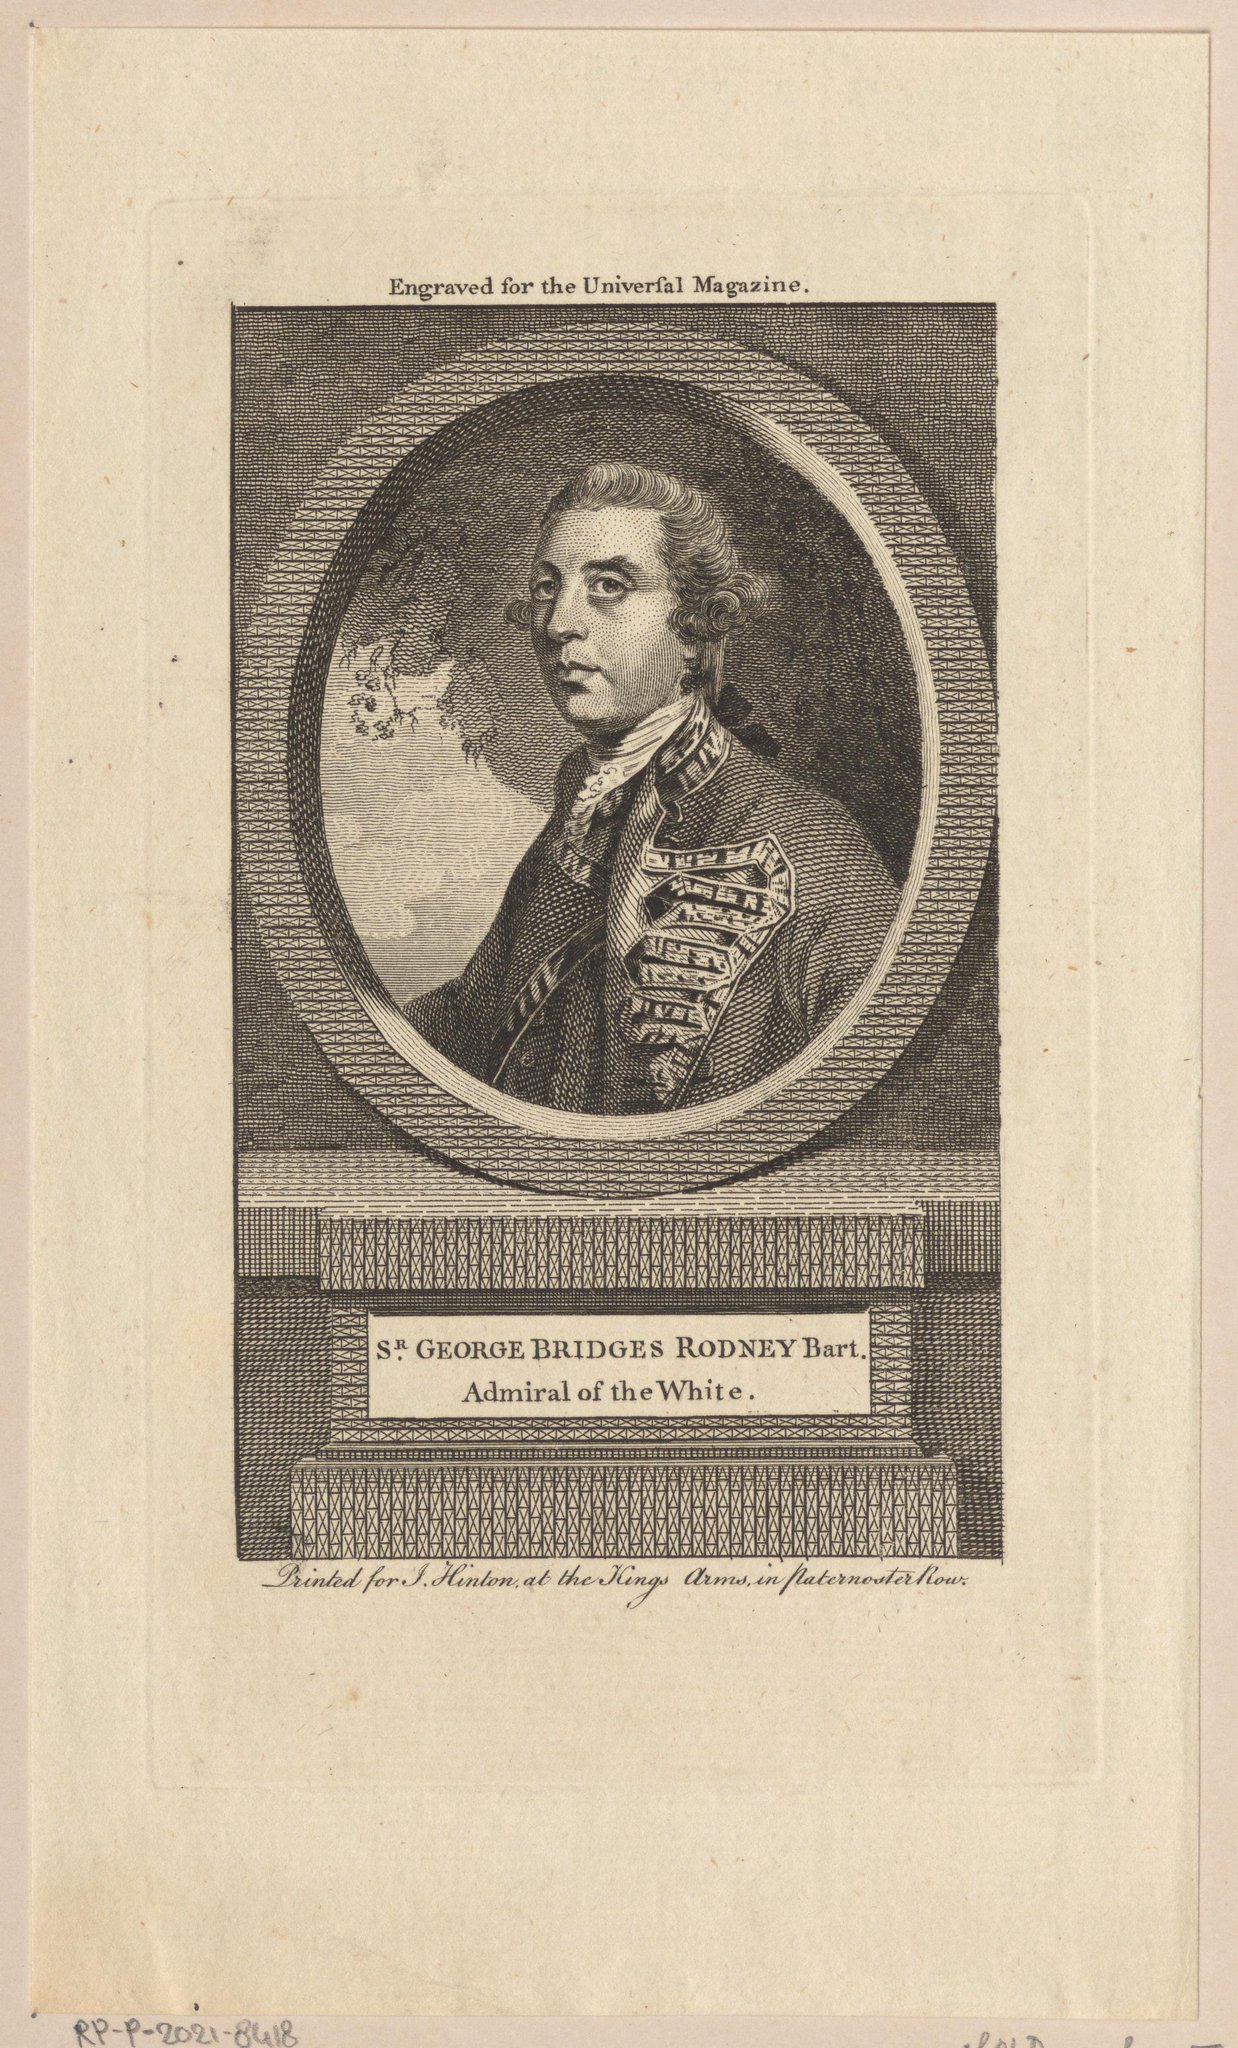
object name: print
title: Portret van baron George Brydges Rodney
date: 1747-1781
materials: paper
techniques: engraving, etching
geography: london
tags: historical persons, commander-in-chief, admiral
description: Prent uit: Universal Magazine, uitgegeven tussen 1747-1814.